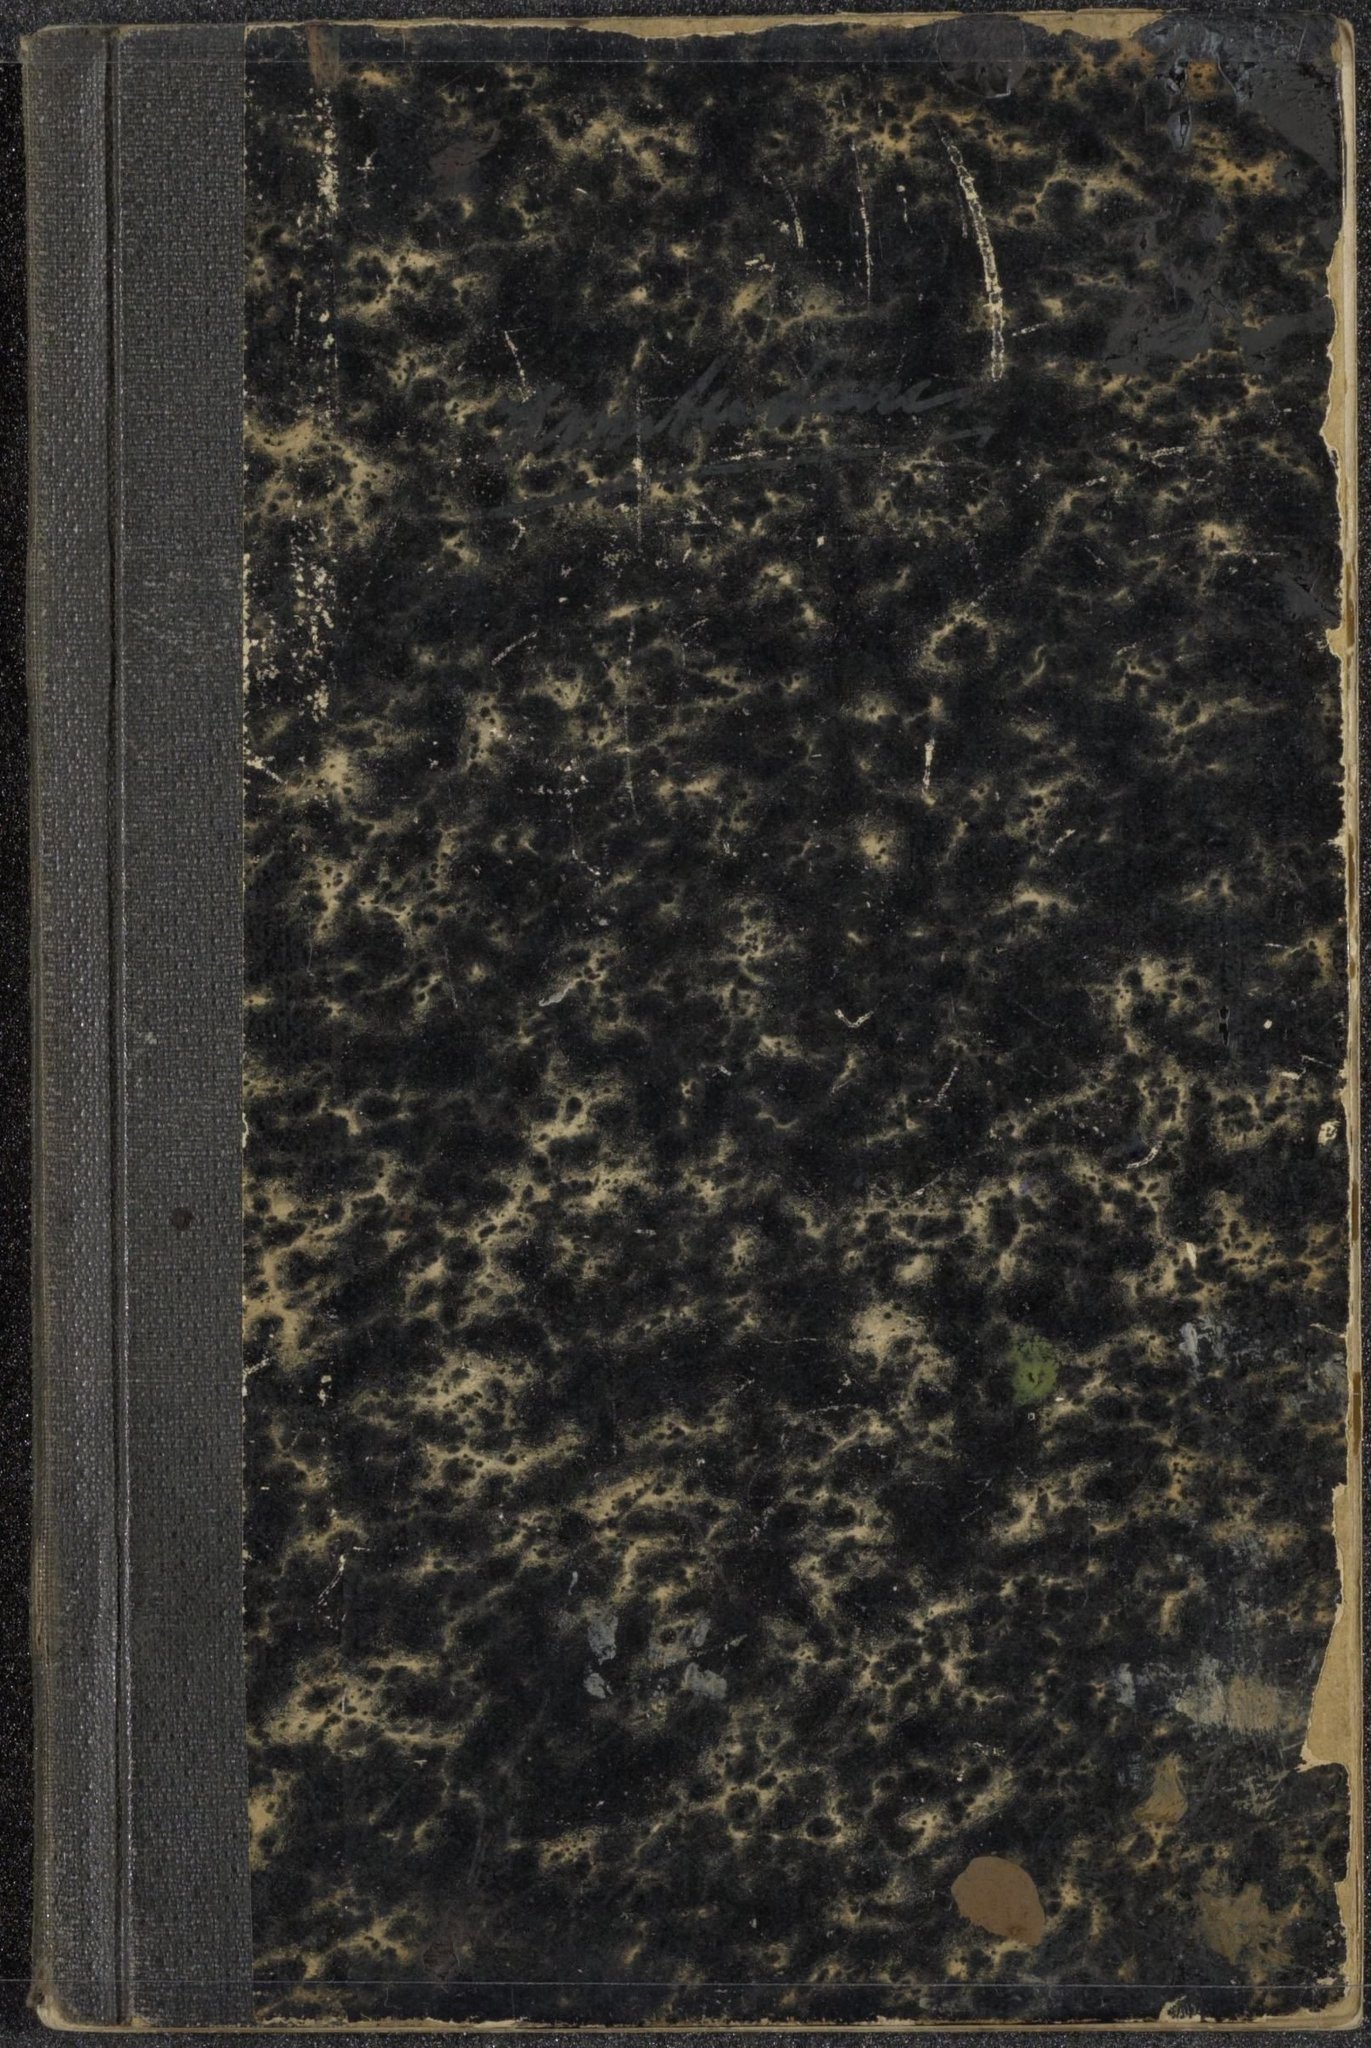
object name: sketchbook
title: Schetsboek met 21 bladen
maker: george hendrik breitner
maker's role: draughtsman, painter, print maker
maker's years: 1857-1923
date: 1895-1898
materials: cardboard, chalk, ink, linen, paper, pencil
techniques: marbling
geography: amsterdam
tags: rotterdam, amsterdam, print maker, draughtsman, george hendrik breitner, portrait, self-portrait of artist, 'en route', traveller under way, street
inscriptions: annotation: ‘Amsterdam’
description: Schetsboek bestaande uit 21 bladen met figuurstudies, gezichten te Amsterdam en een zelfportret. Achterin een losse foto van een foto.